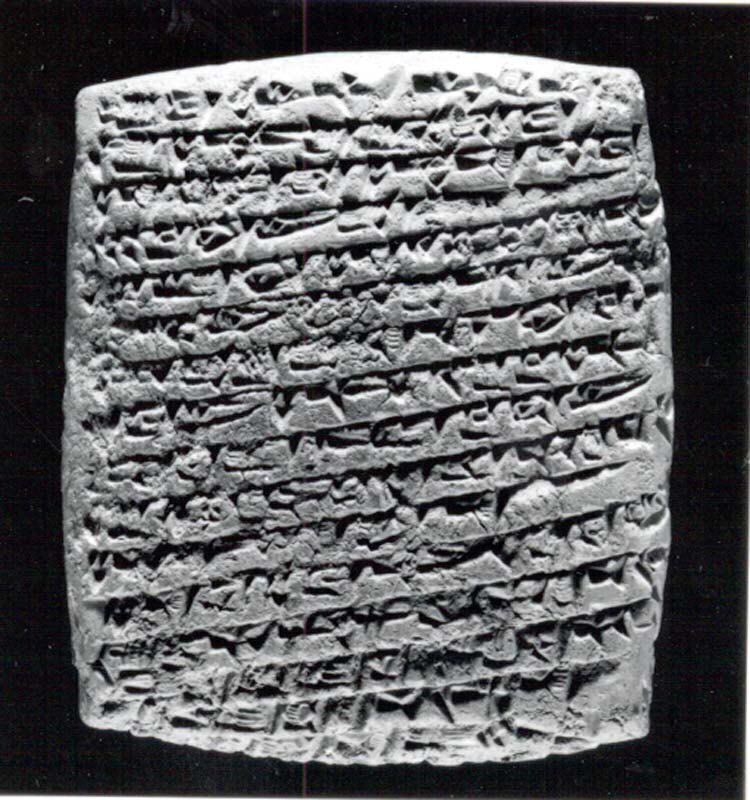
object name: cuneiform tablet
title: Cuneiform tablet: private letter concerning consignment of textiles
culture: assyrian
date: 2000-1801 BCE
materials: clay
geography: anatolia